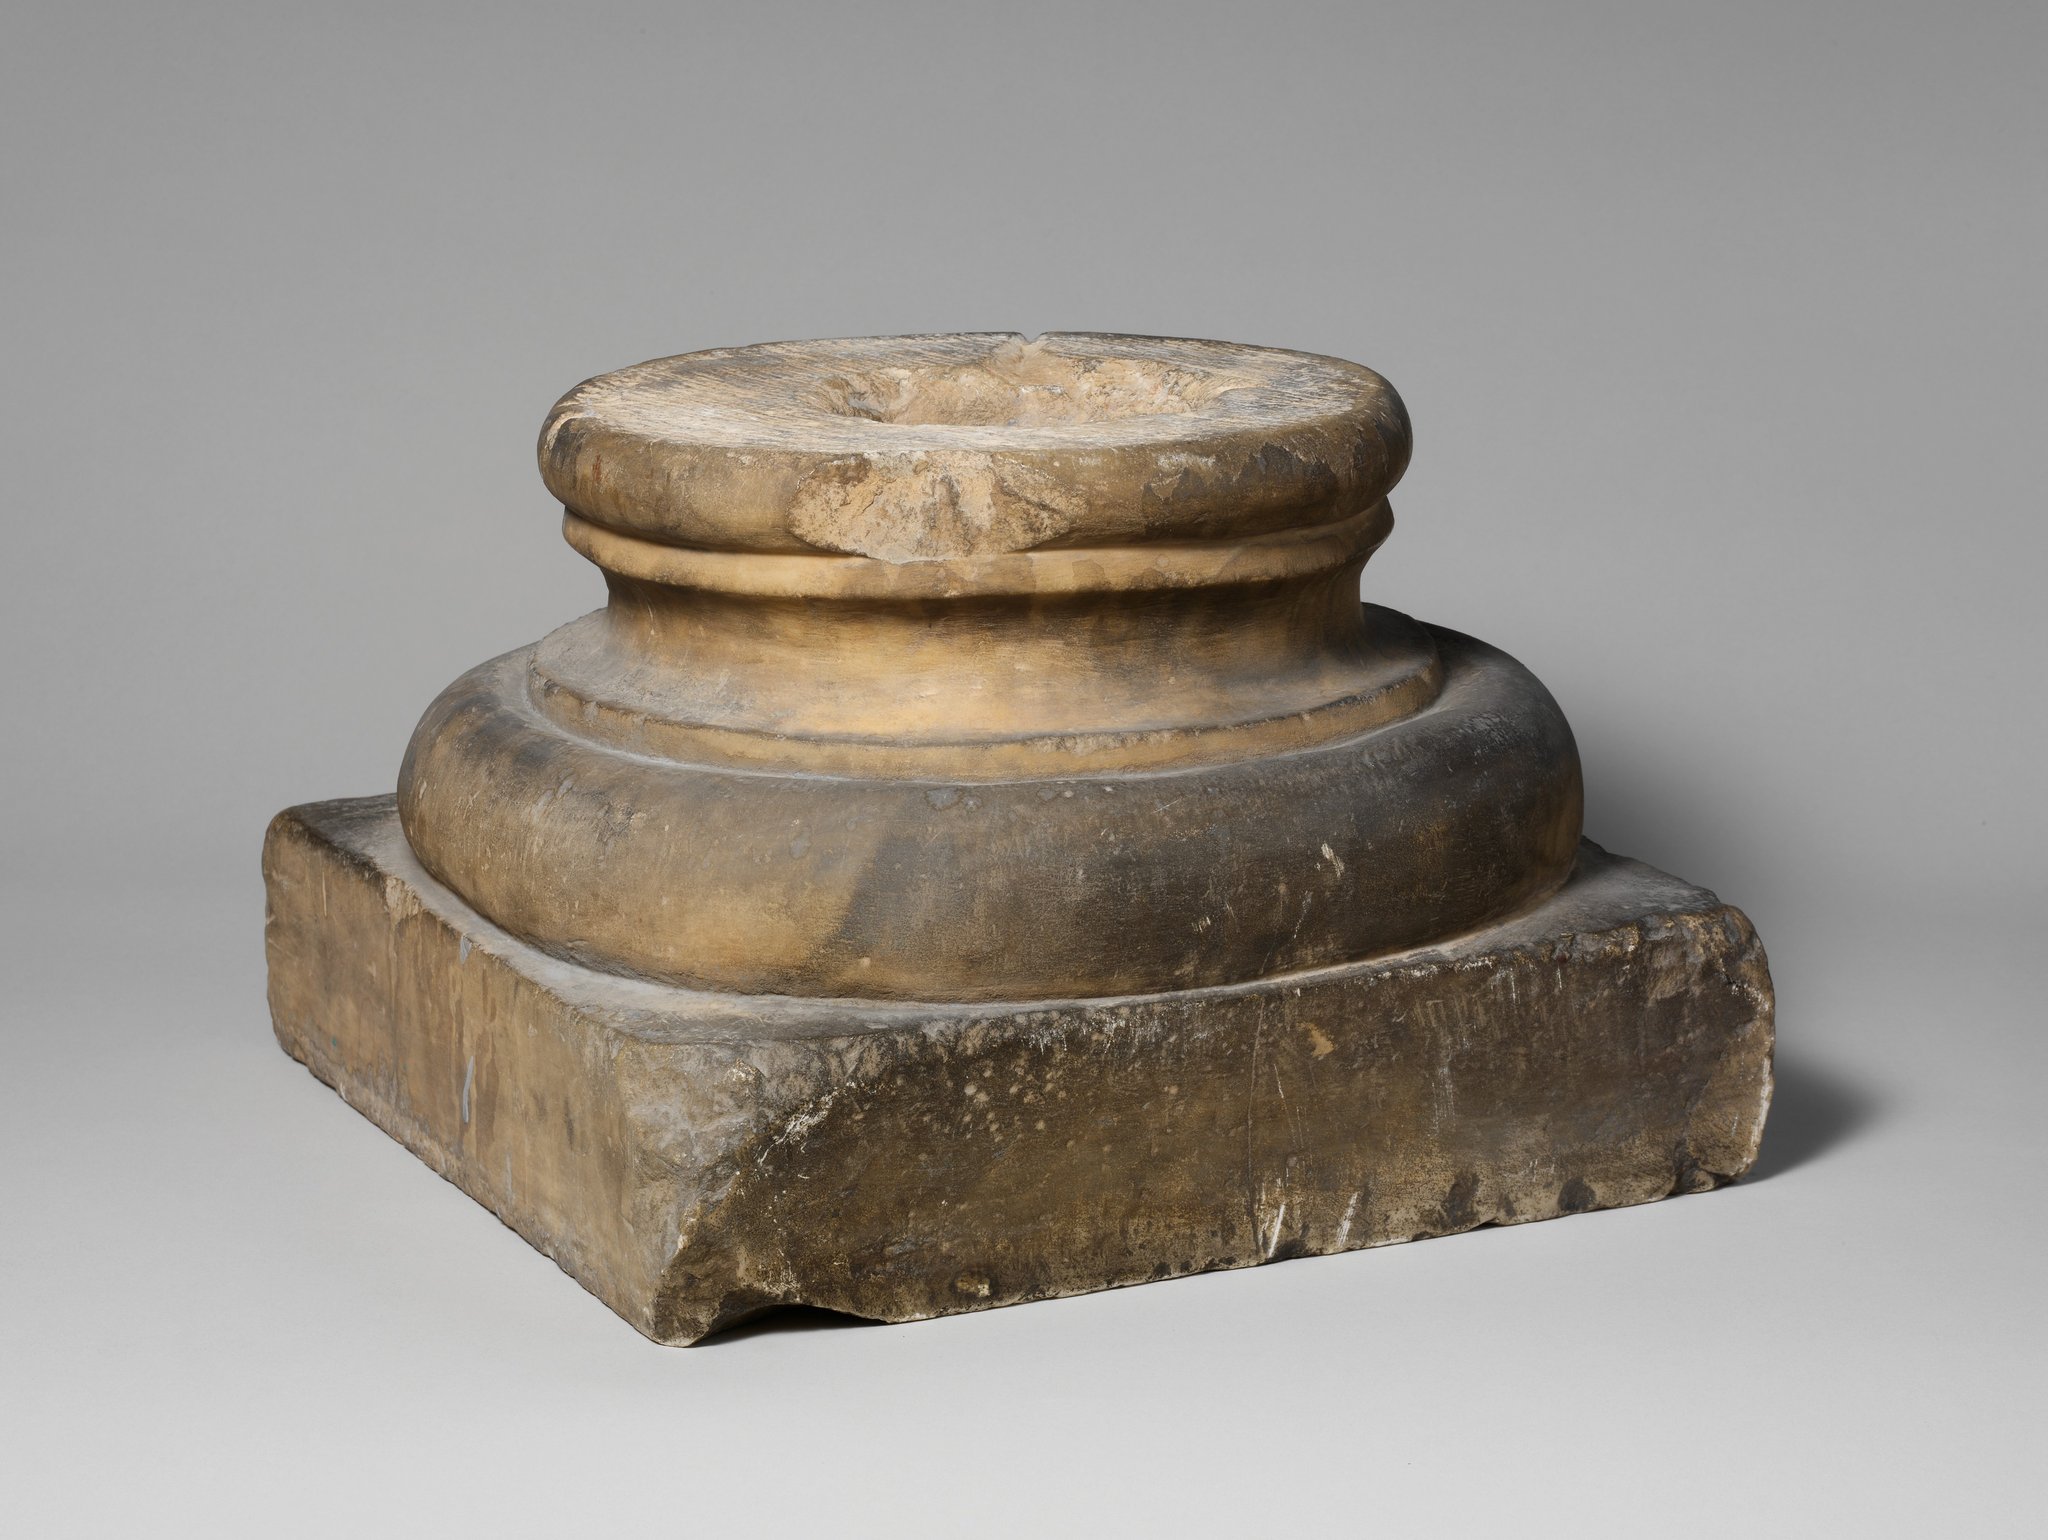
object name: base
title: Column Base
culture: northeast italian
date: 1101-1200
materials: marble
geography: italy